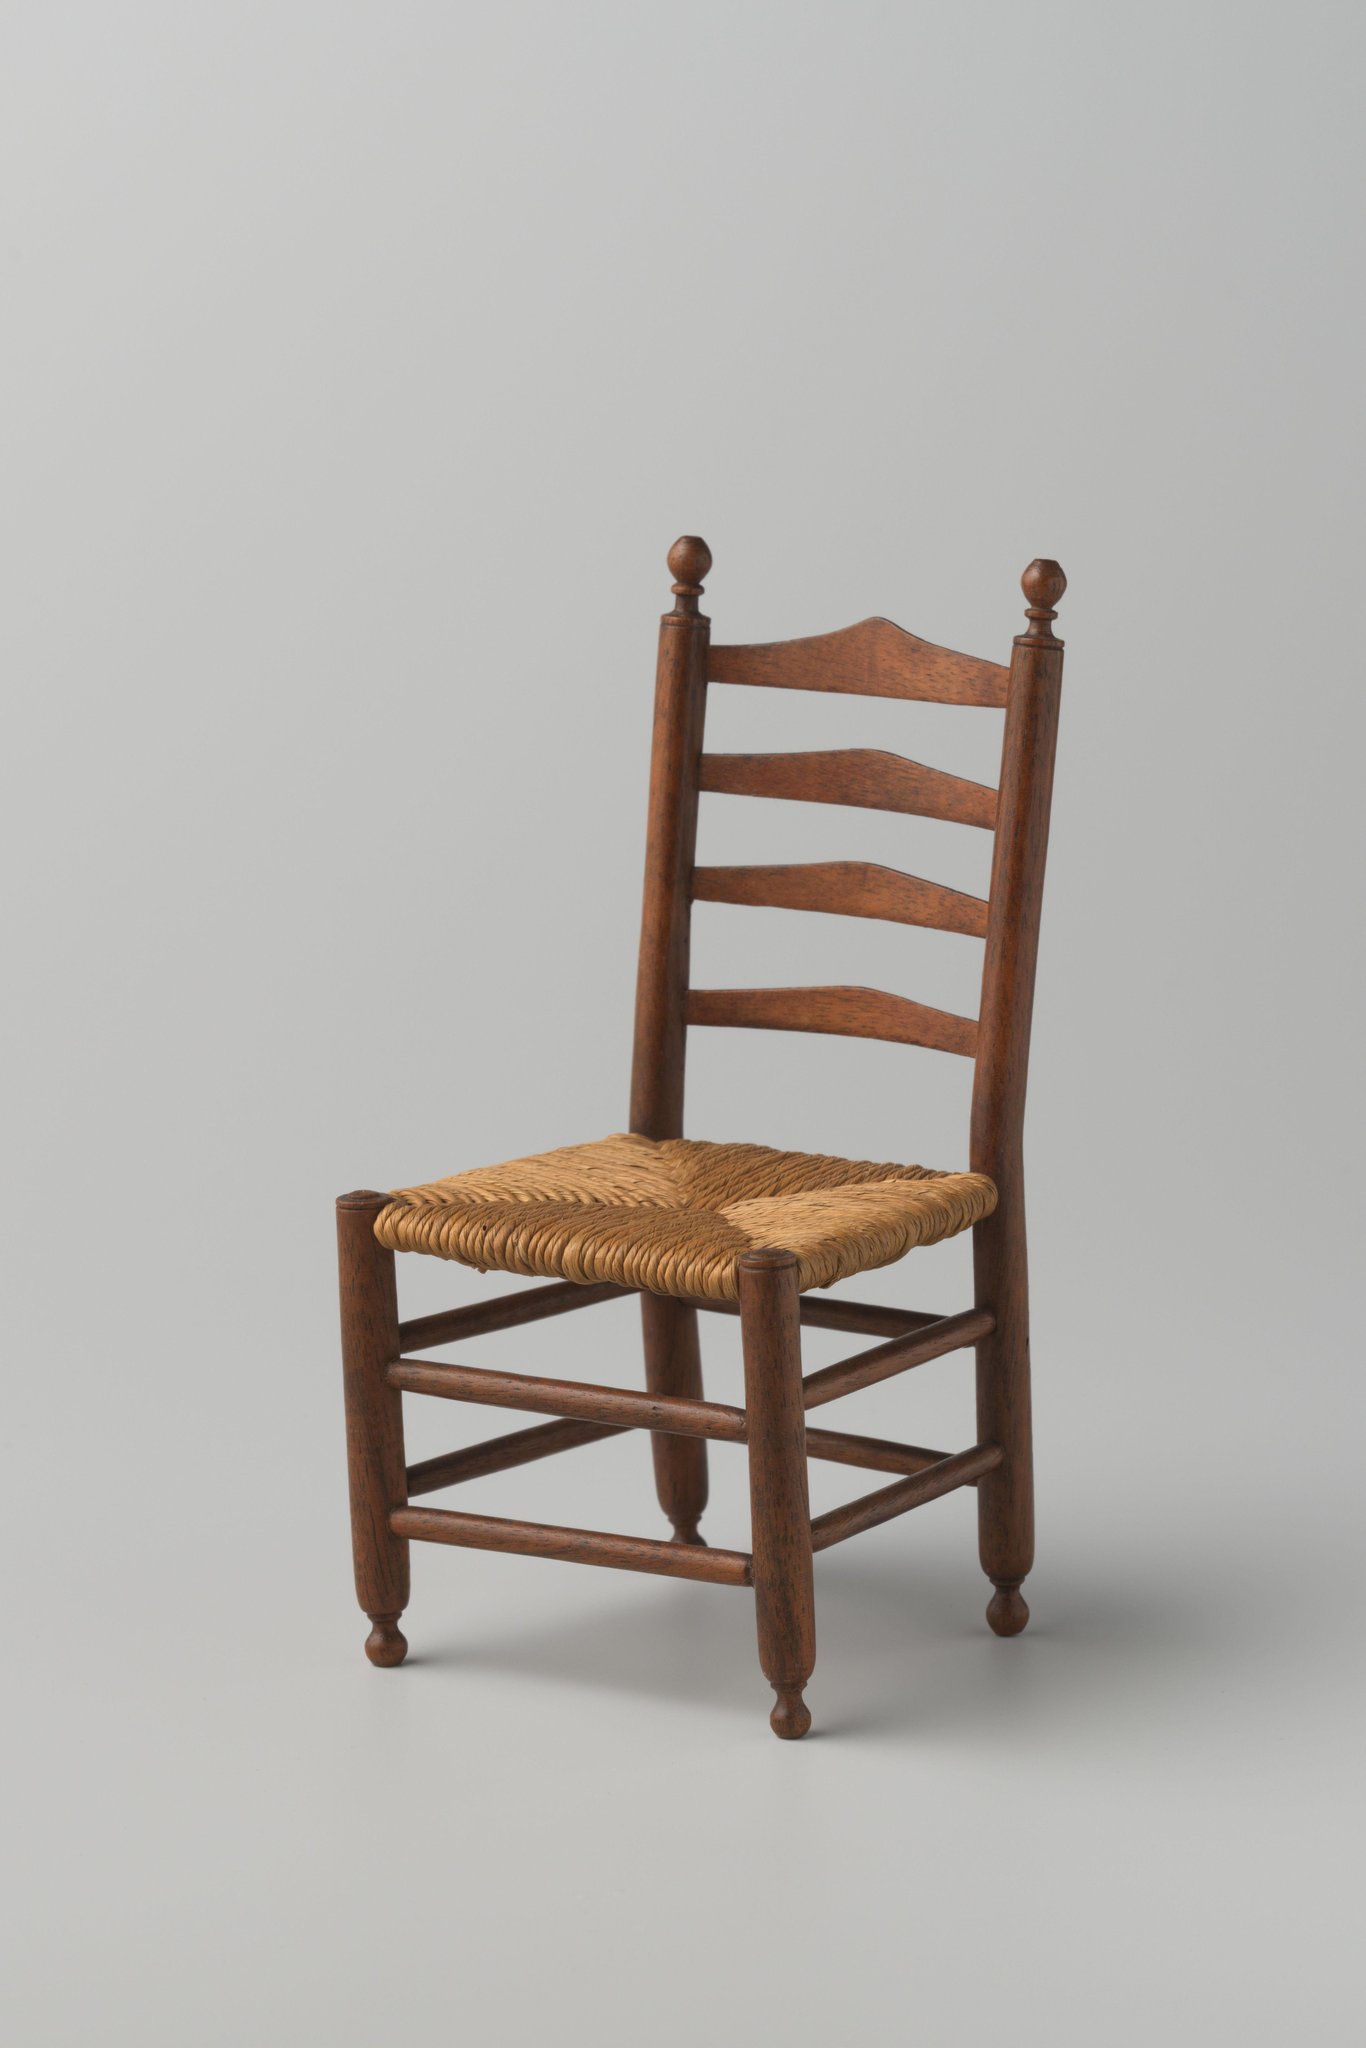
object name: miniature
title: Knopstoel met matten zitting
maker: Anonymous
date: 1690-1710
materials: fiber, wood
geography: amsterdam